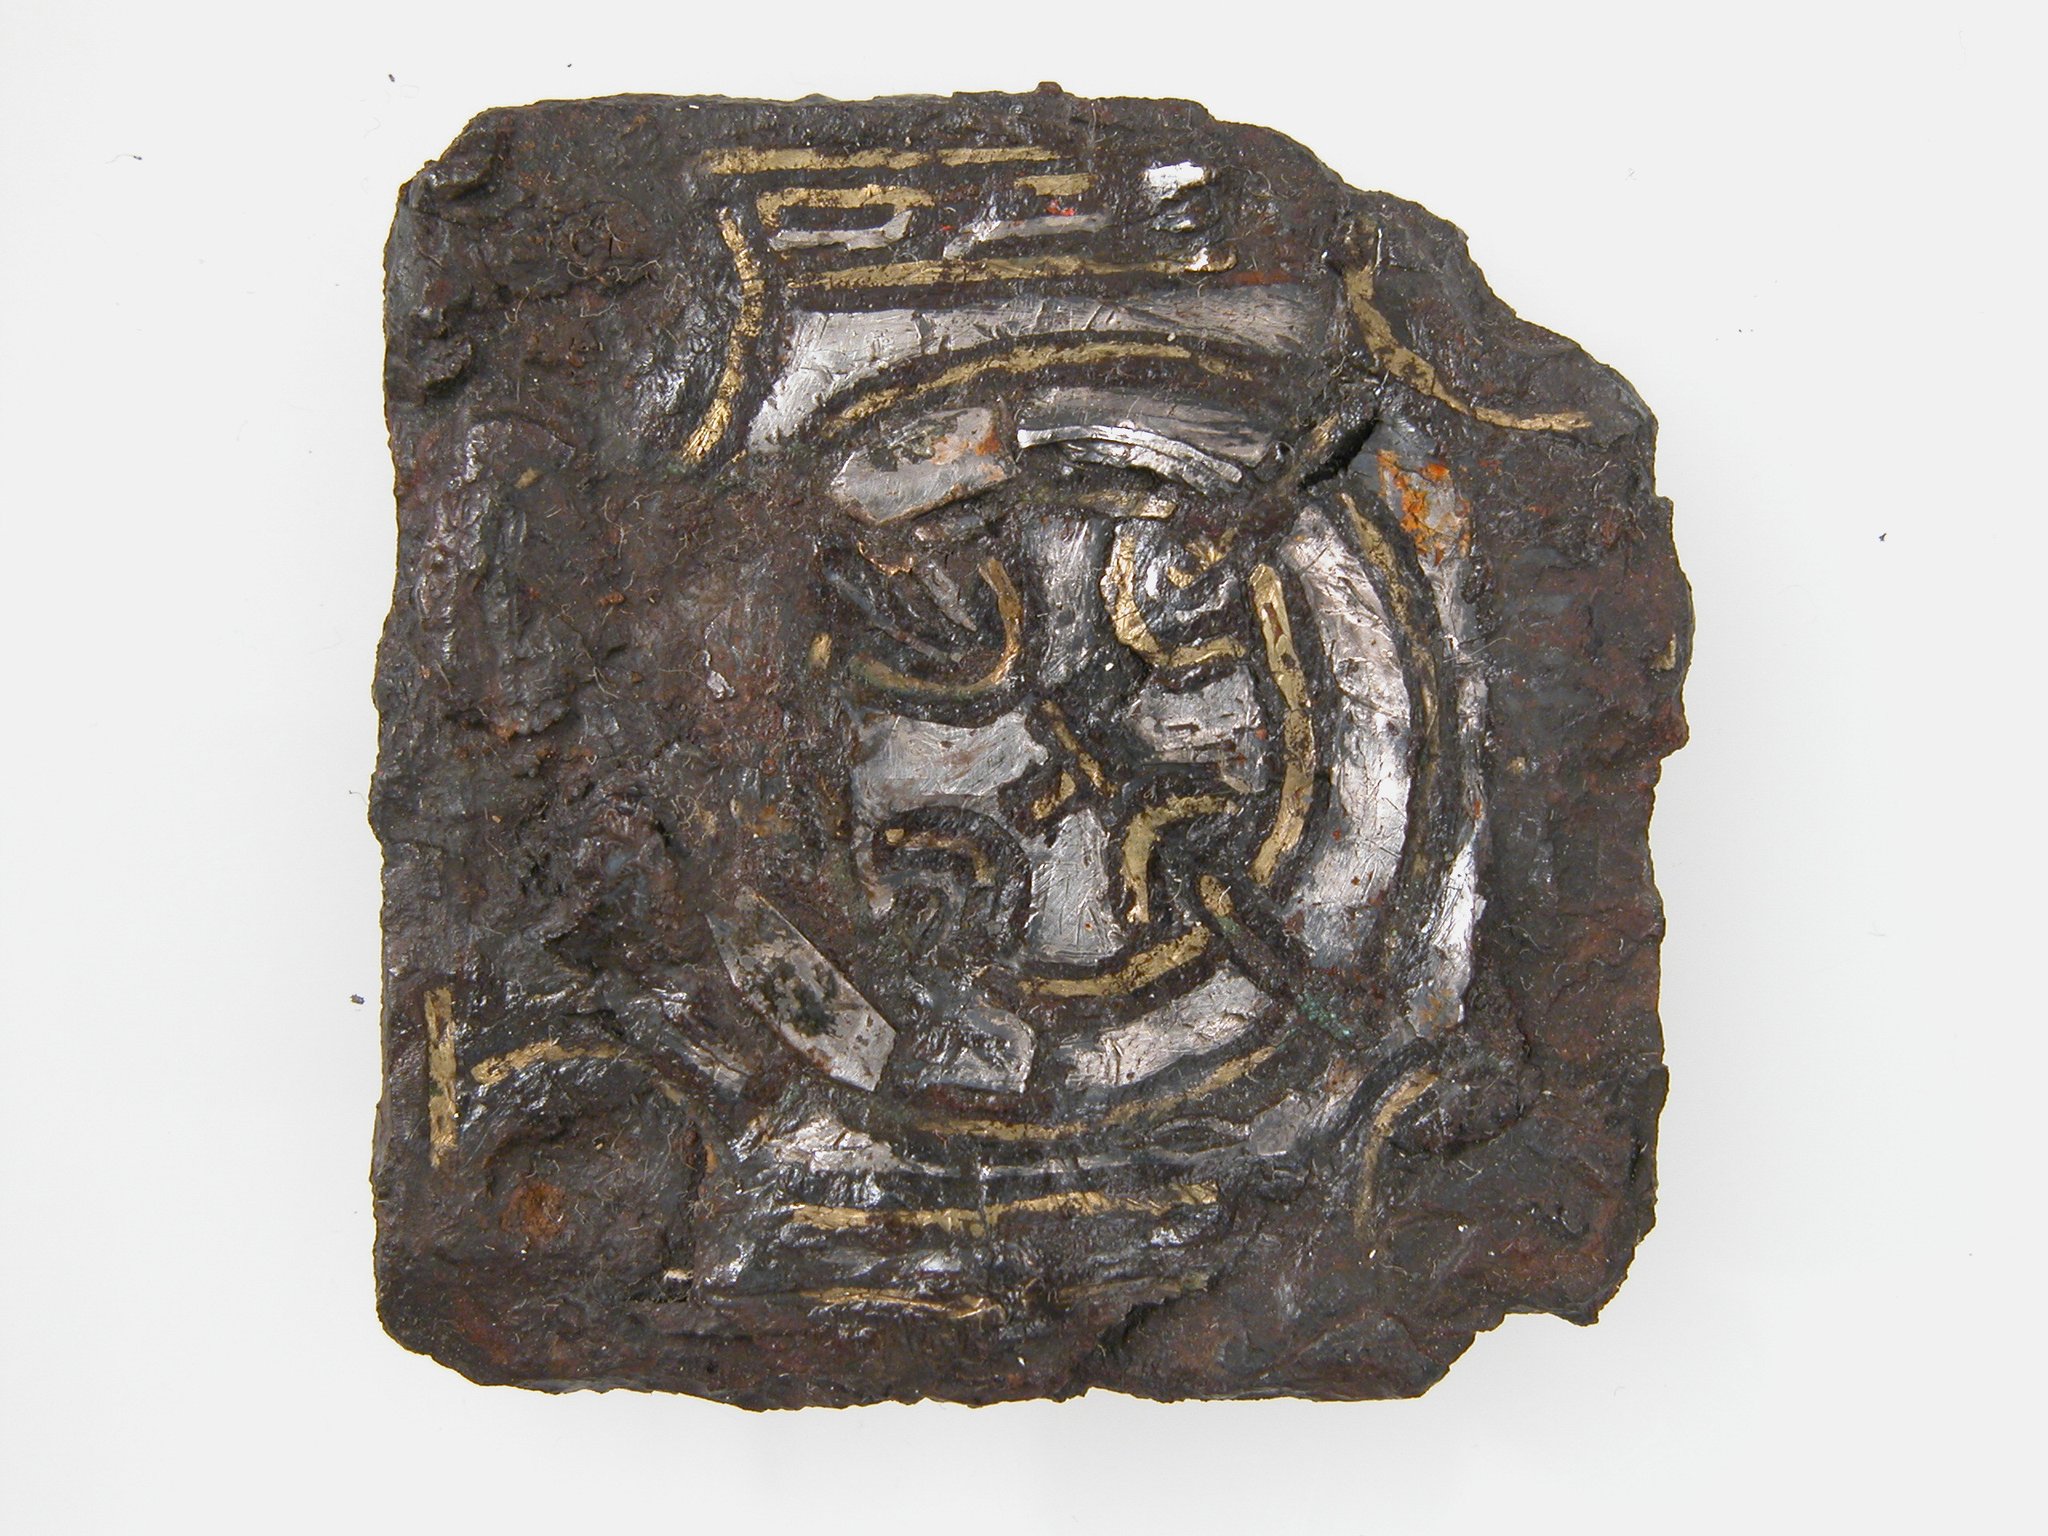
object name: belt plate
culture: frankish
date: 501-700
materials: brass, iron, silver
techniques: inlay